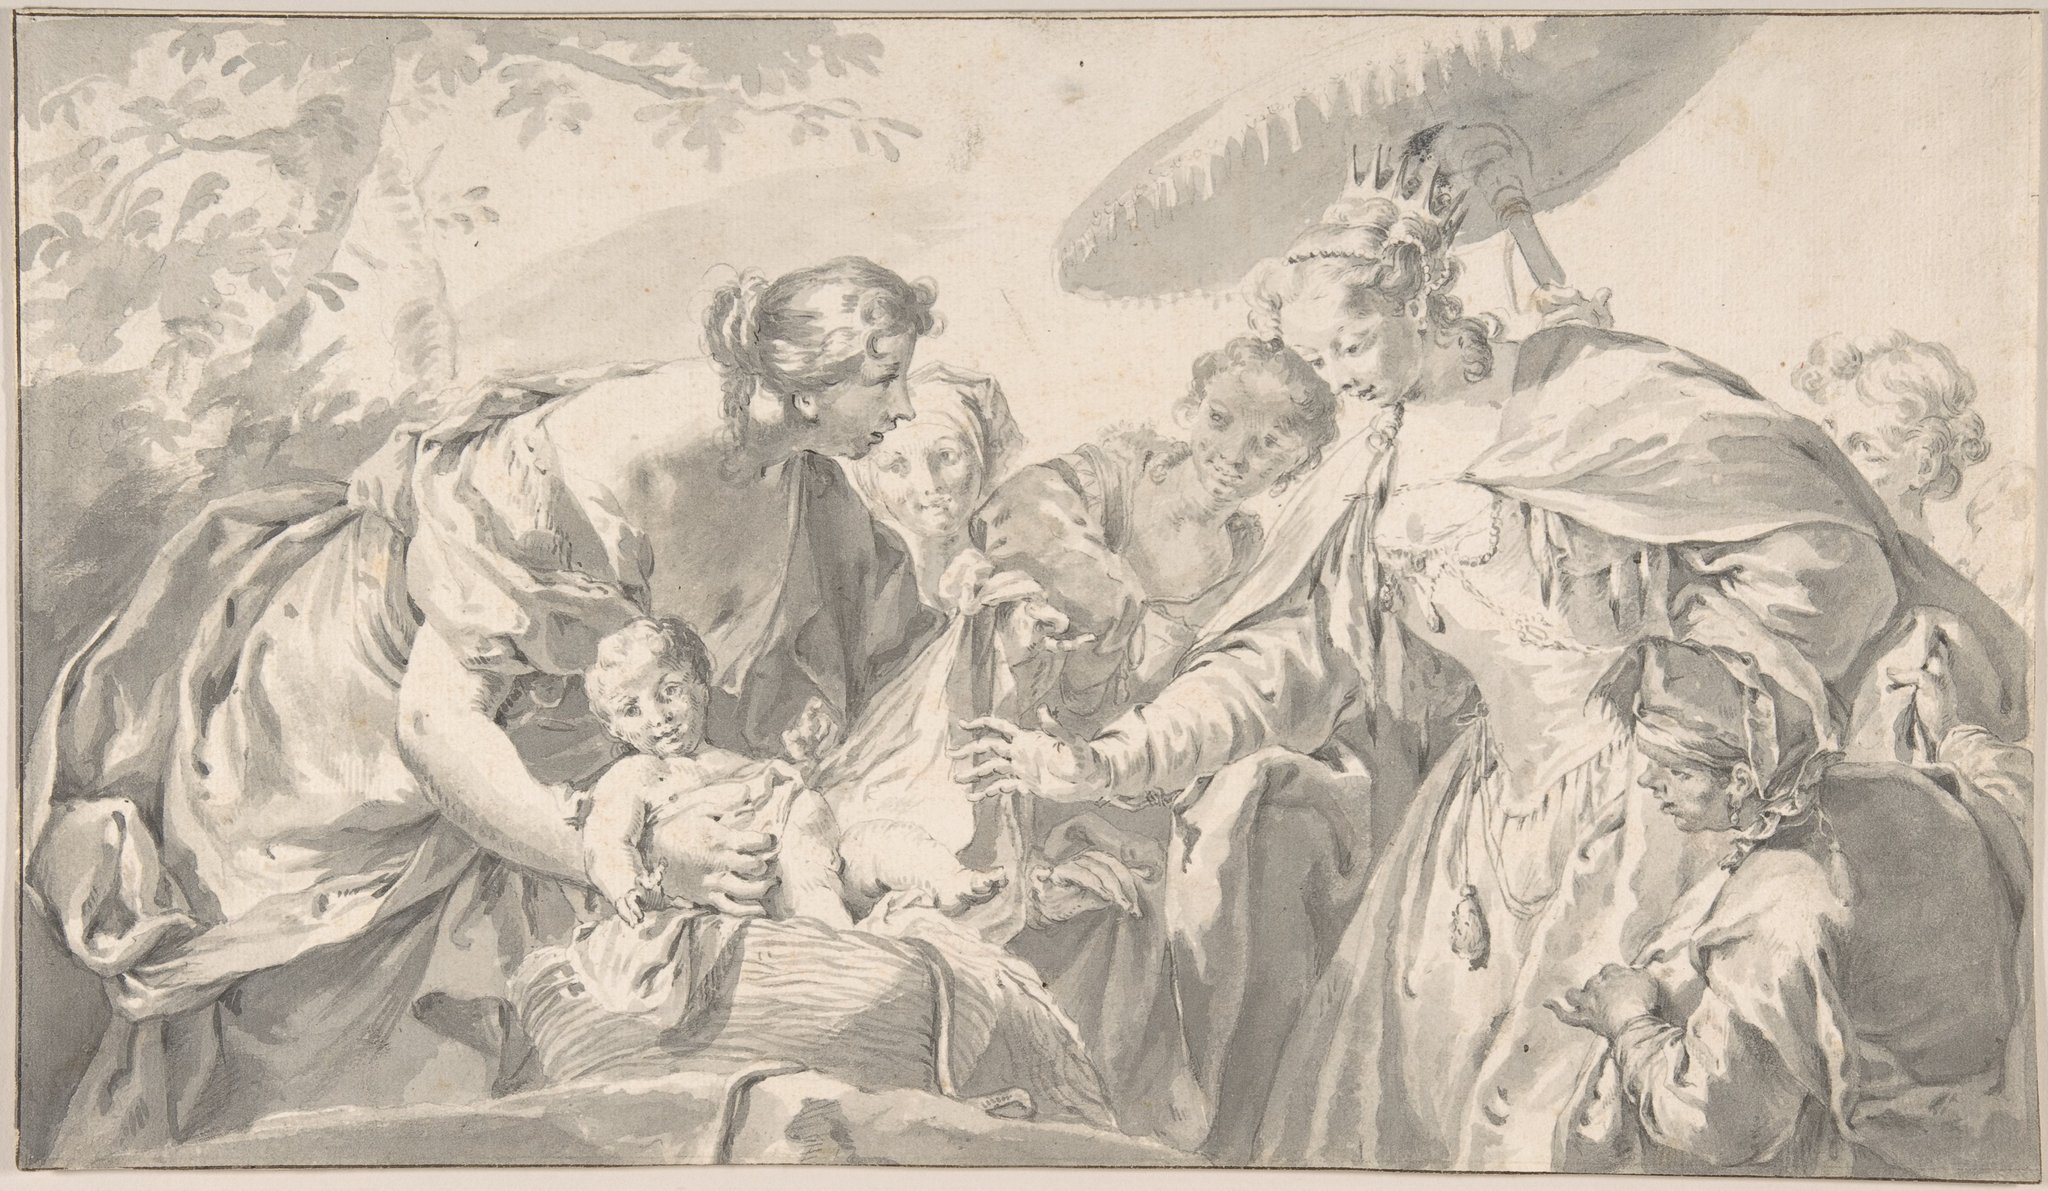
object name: drawing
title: The Finding of Moses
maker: anton kern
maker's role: artist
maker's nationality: german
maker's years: 1710-1747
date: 1725-1747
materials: chalk, ink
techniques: brush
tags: women,moses